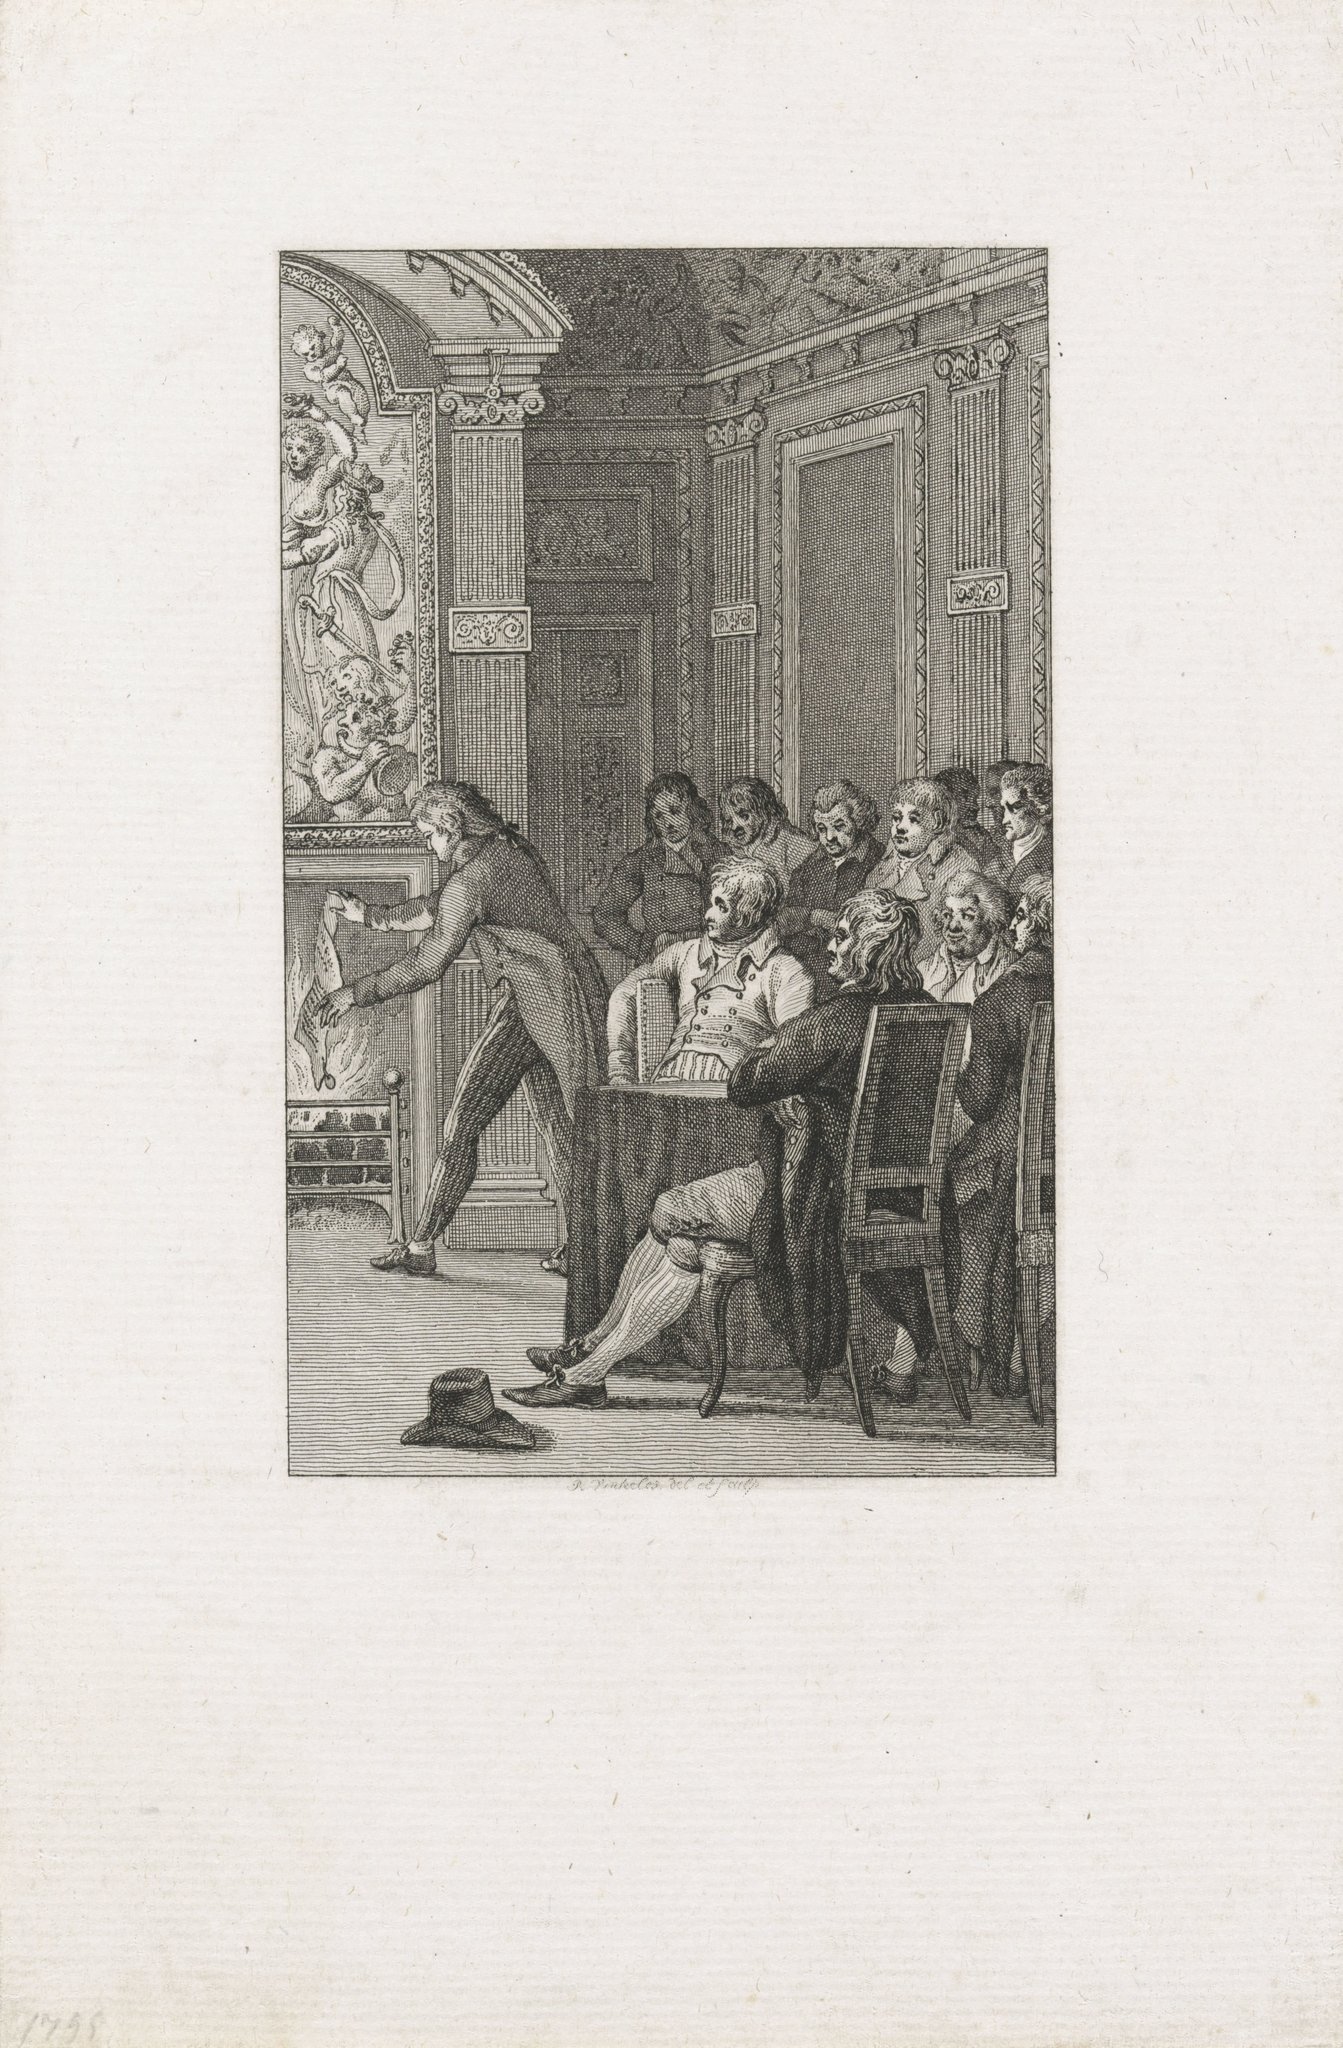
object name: history print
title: Van Laar verbrandt de Acte van Garantie, 1795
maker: reinier vinkeles (i)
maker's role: draughtsman, print maker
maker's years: 1741-1816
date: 1803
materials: paper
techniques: engraving, etching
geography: northern netherlands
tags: measures taken by revolutionary council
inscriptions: collector's mark: Lugt 2228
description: Gebruikt als illustratie in:P.A. Loosjes. Vaderlandsche historie, vervattende de geschiedenissen, der Vereenigde Nederlanden (...). Ten onmiddelyken vervolge van Wagenaar's Vaderlandsche historie. Amsterdam: Johannes Allart, dl. 30 (1803).